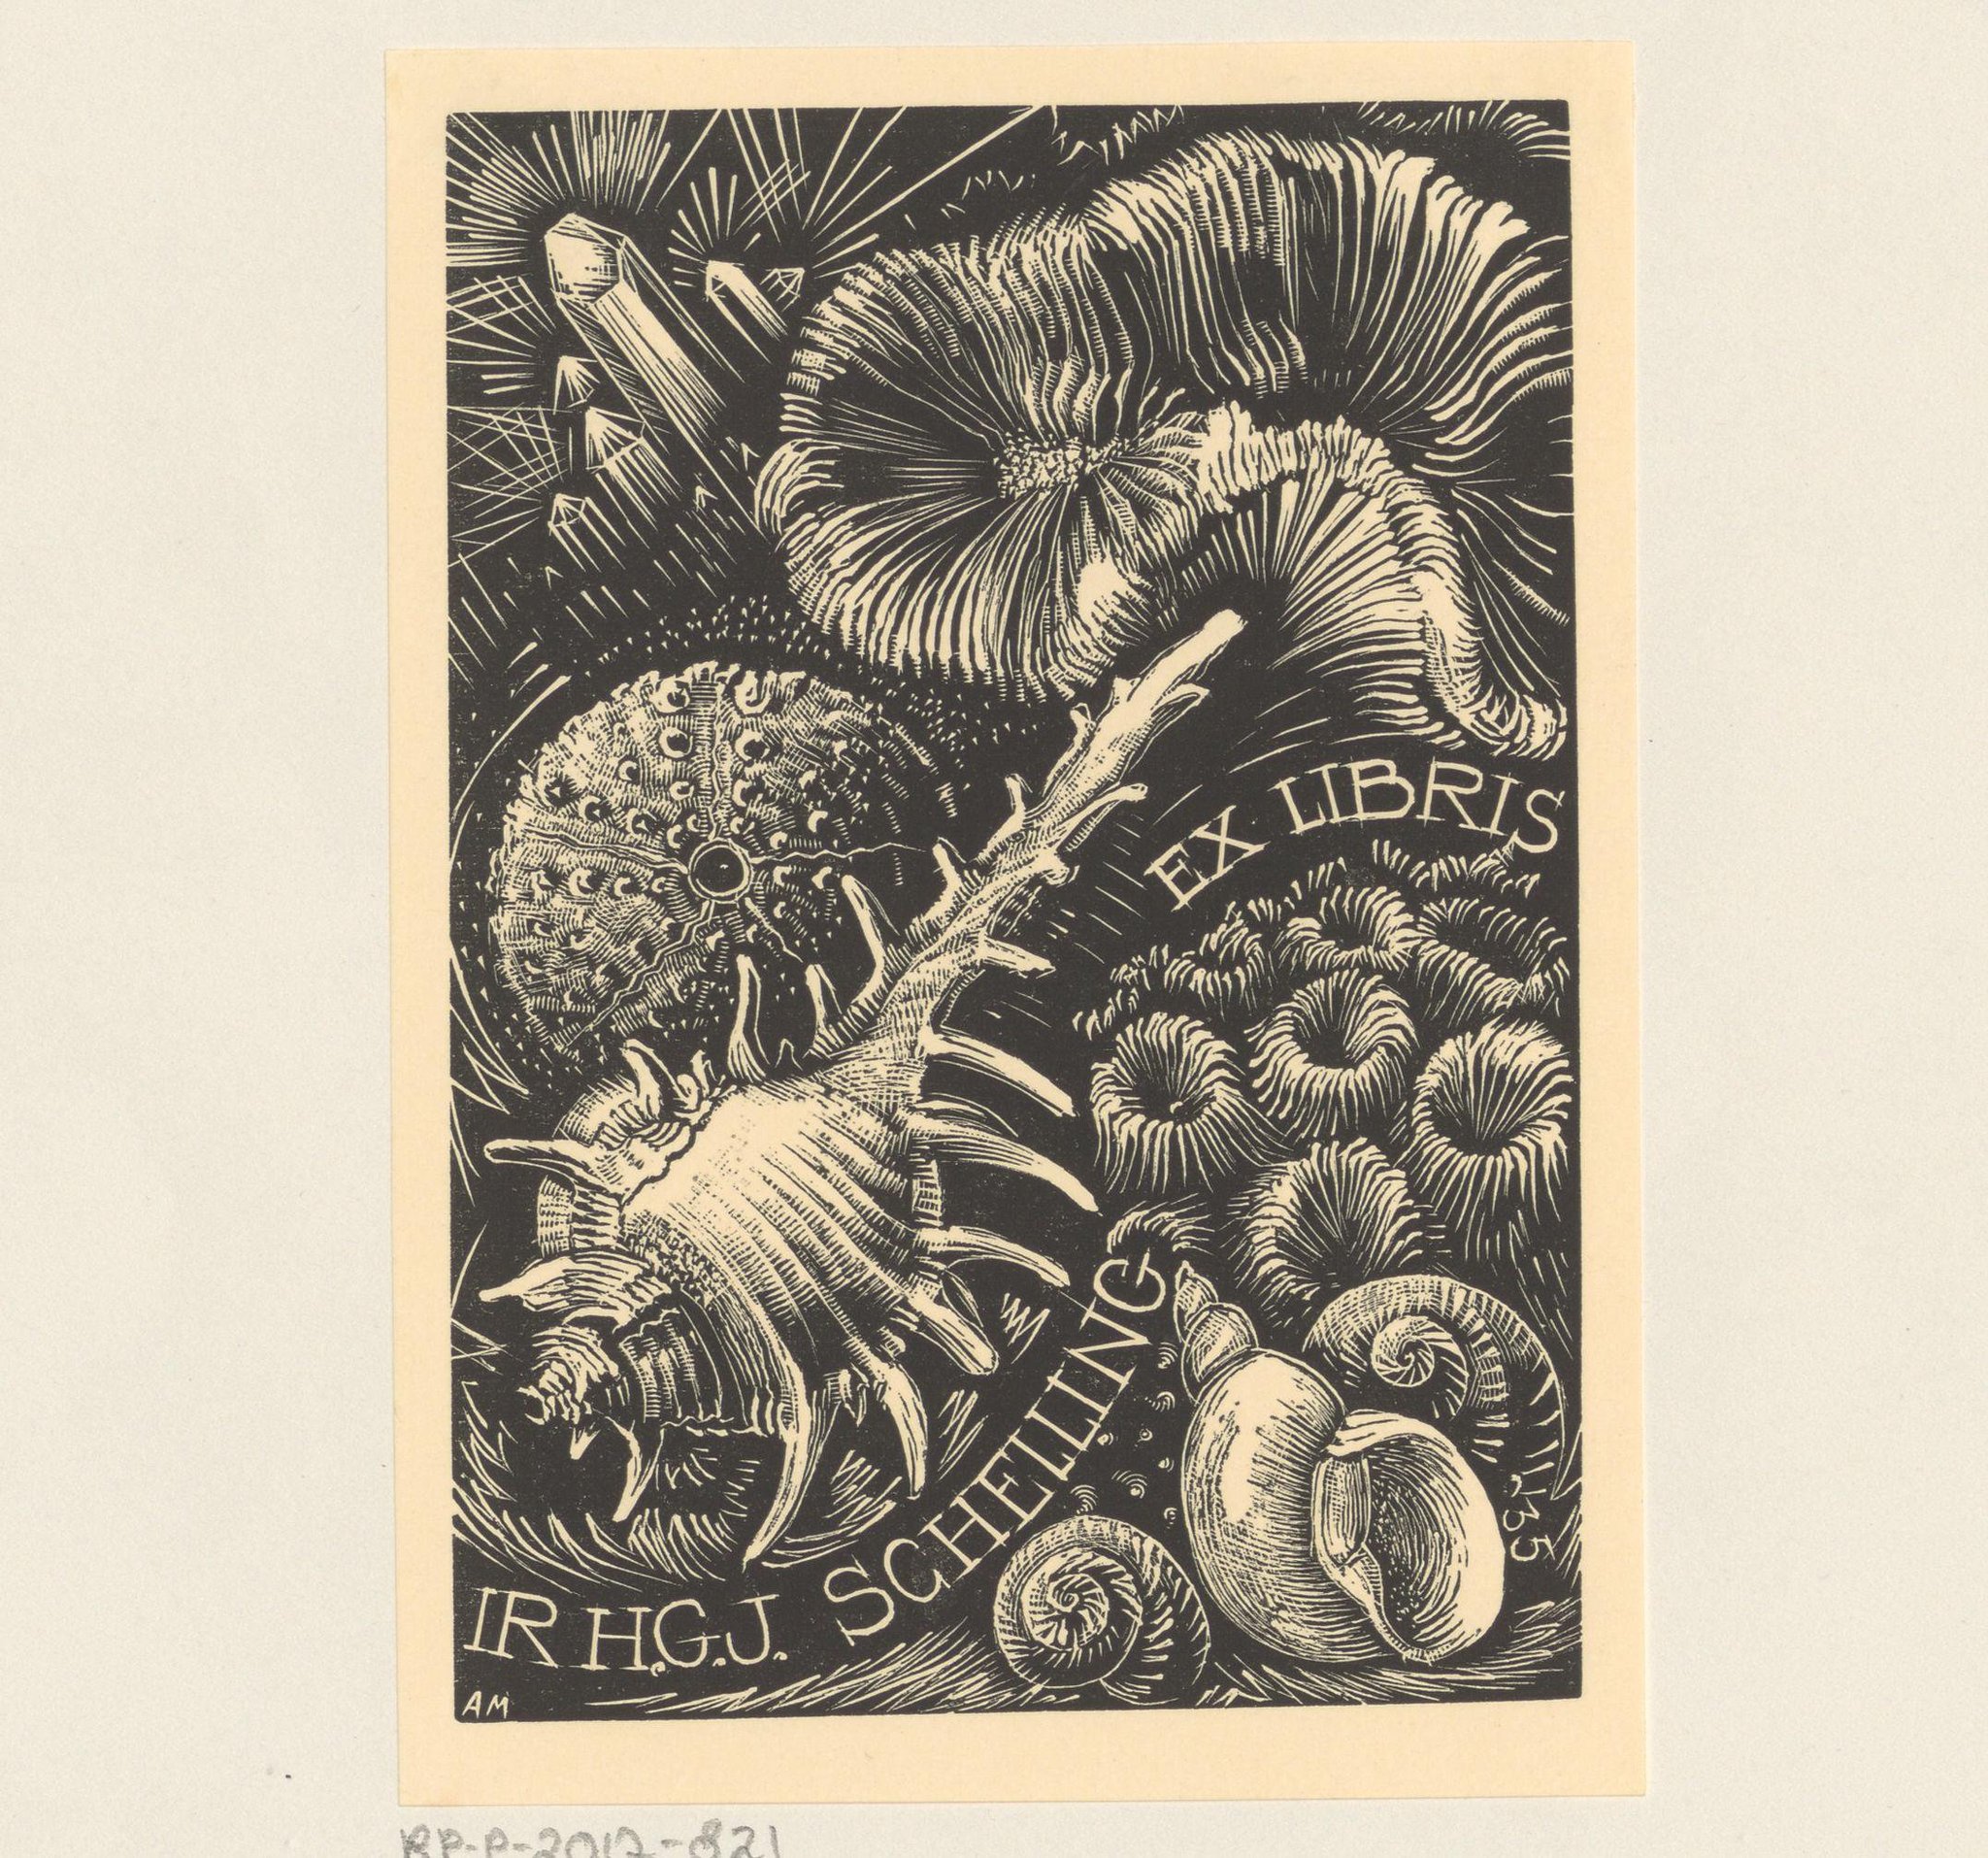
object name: bookplate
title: Ex libris van H.G.J. Schelling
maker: agta meijer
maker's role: painter, print maker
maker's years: 1908-1944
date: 1935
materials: paper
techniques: engraving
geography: netherlands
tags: hermanus gerardus jacob schelling, flowers: anemone, deep sea, scallop, shell ~ ornament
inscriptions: inscription: ‘Houtgravure / Agta Meijer 1935’